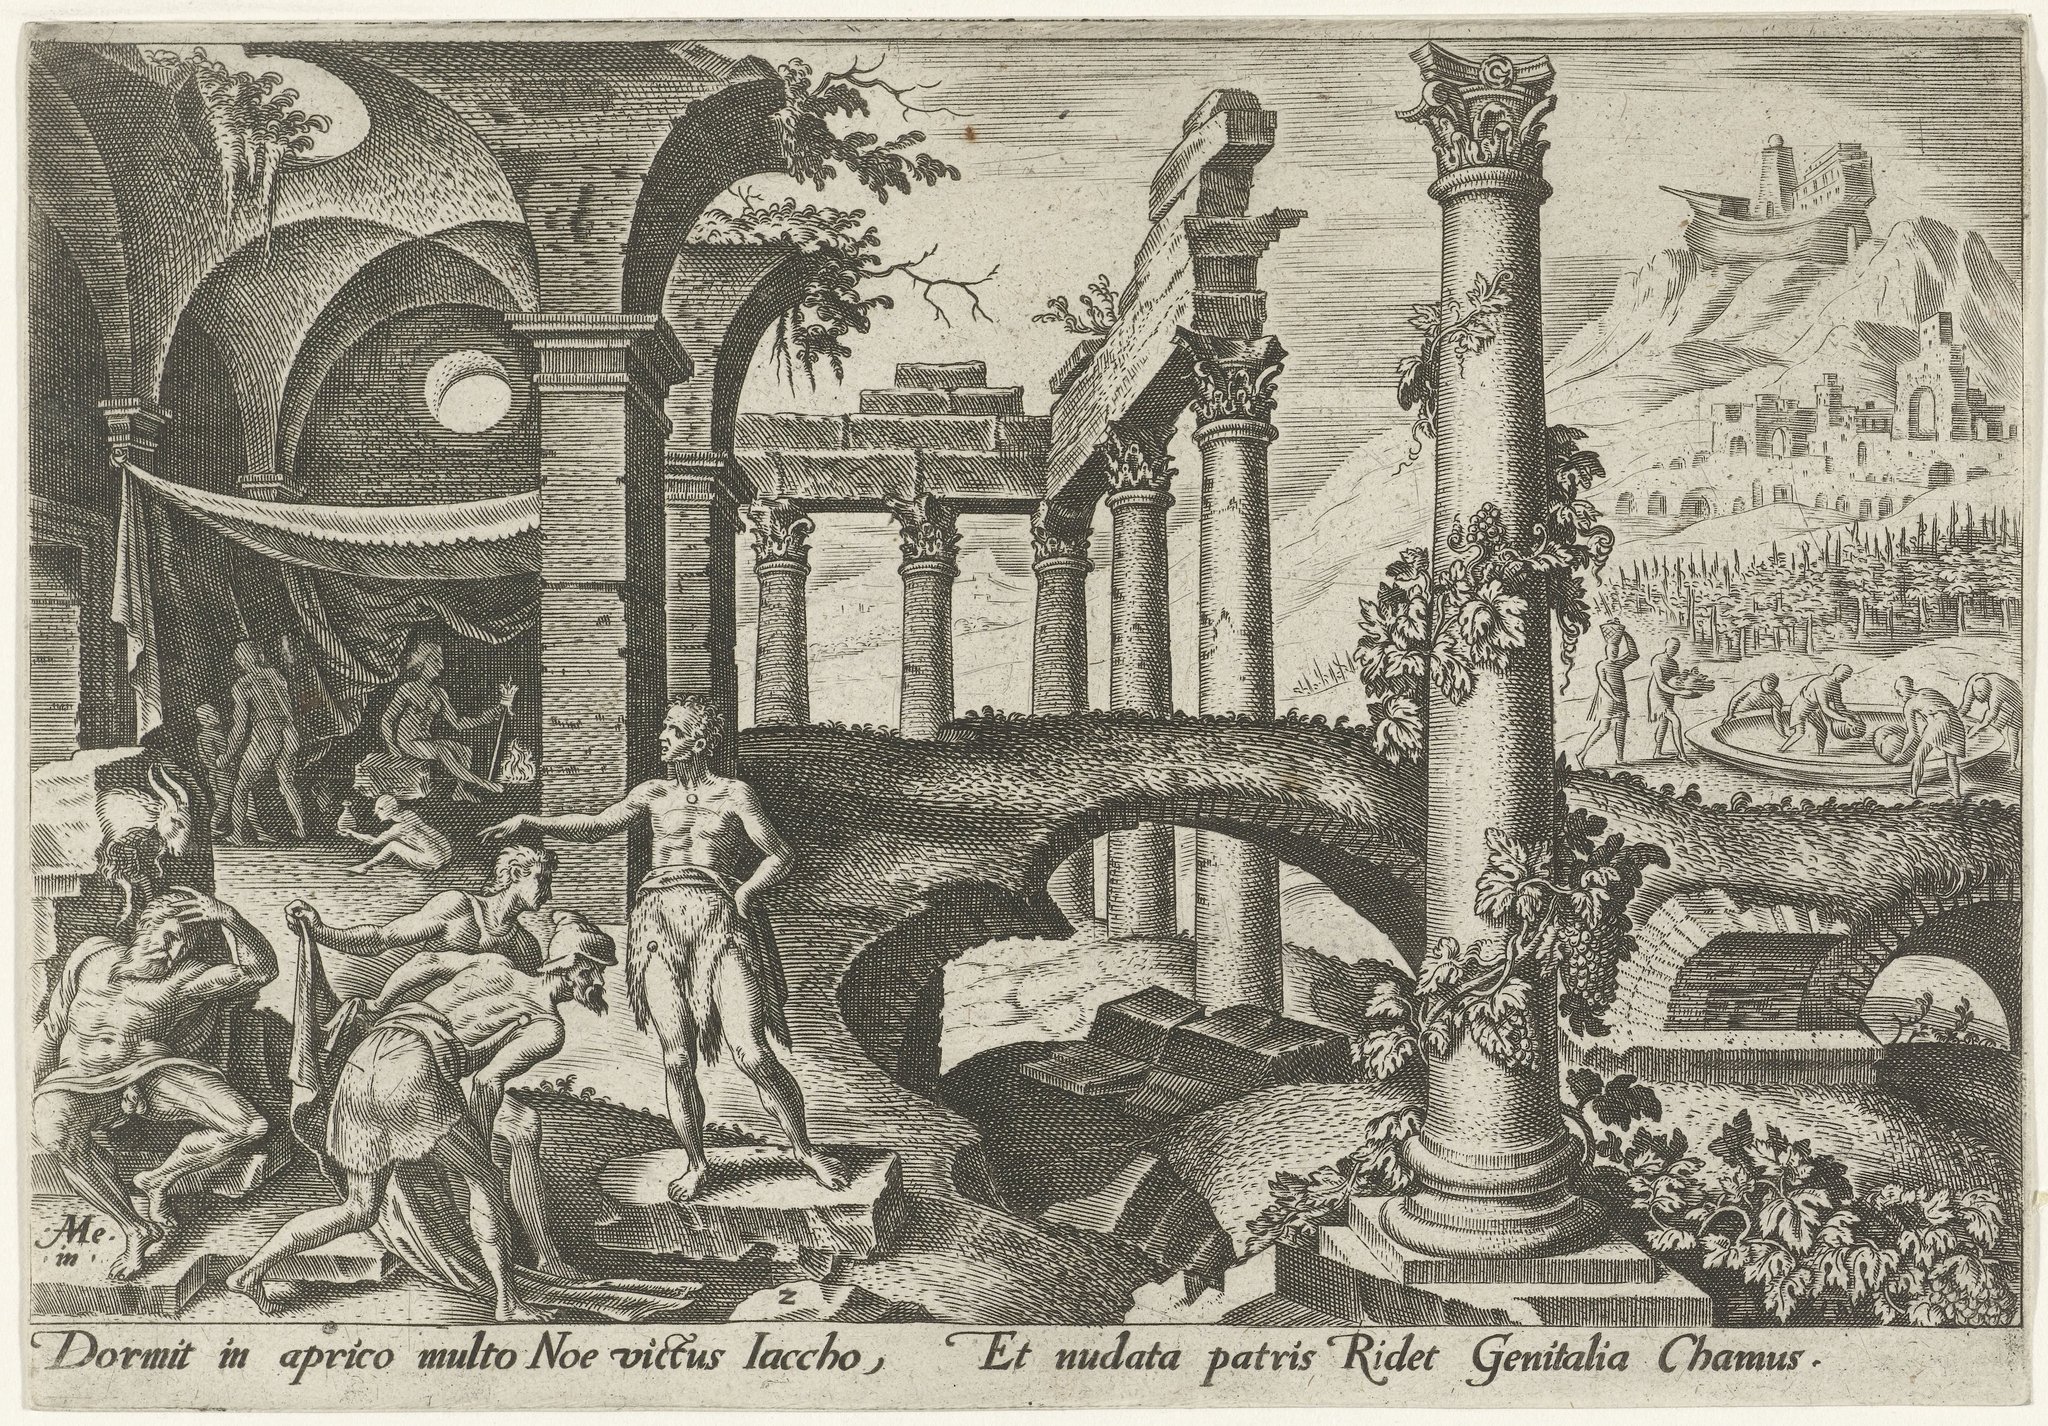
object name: print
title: De onheilsdagen van het Joodse volk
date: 1569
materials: paper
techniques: engraving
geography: haarlem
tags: the mocking of noah: ham finds his father (partially) naked sleeping out of doors (or in his tent, or in the vineyard cottage); ham calls his brothers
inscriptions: caption: ‘Dormit in aprico multo Noe victus Iaccho / Et nudata patris Ridet Genitalia Chamus.’, number: ‘2’, signature: ‘MHe./ in.’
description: De dronken Noach ligt naakt te slapen op de grond en wordt gevonden door zijn zoons, die hem uitlachen vanwege zijn toestand. Noach ligt voor de ruïne van een klassiek gebouw. In het gebouw bivakkeert onder een baldakijn een gezin met twee kinderen.